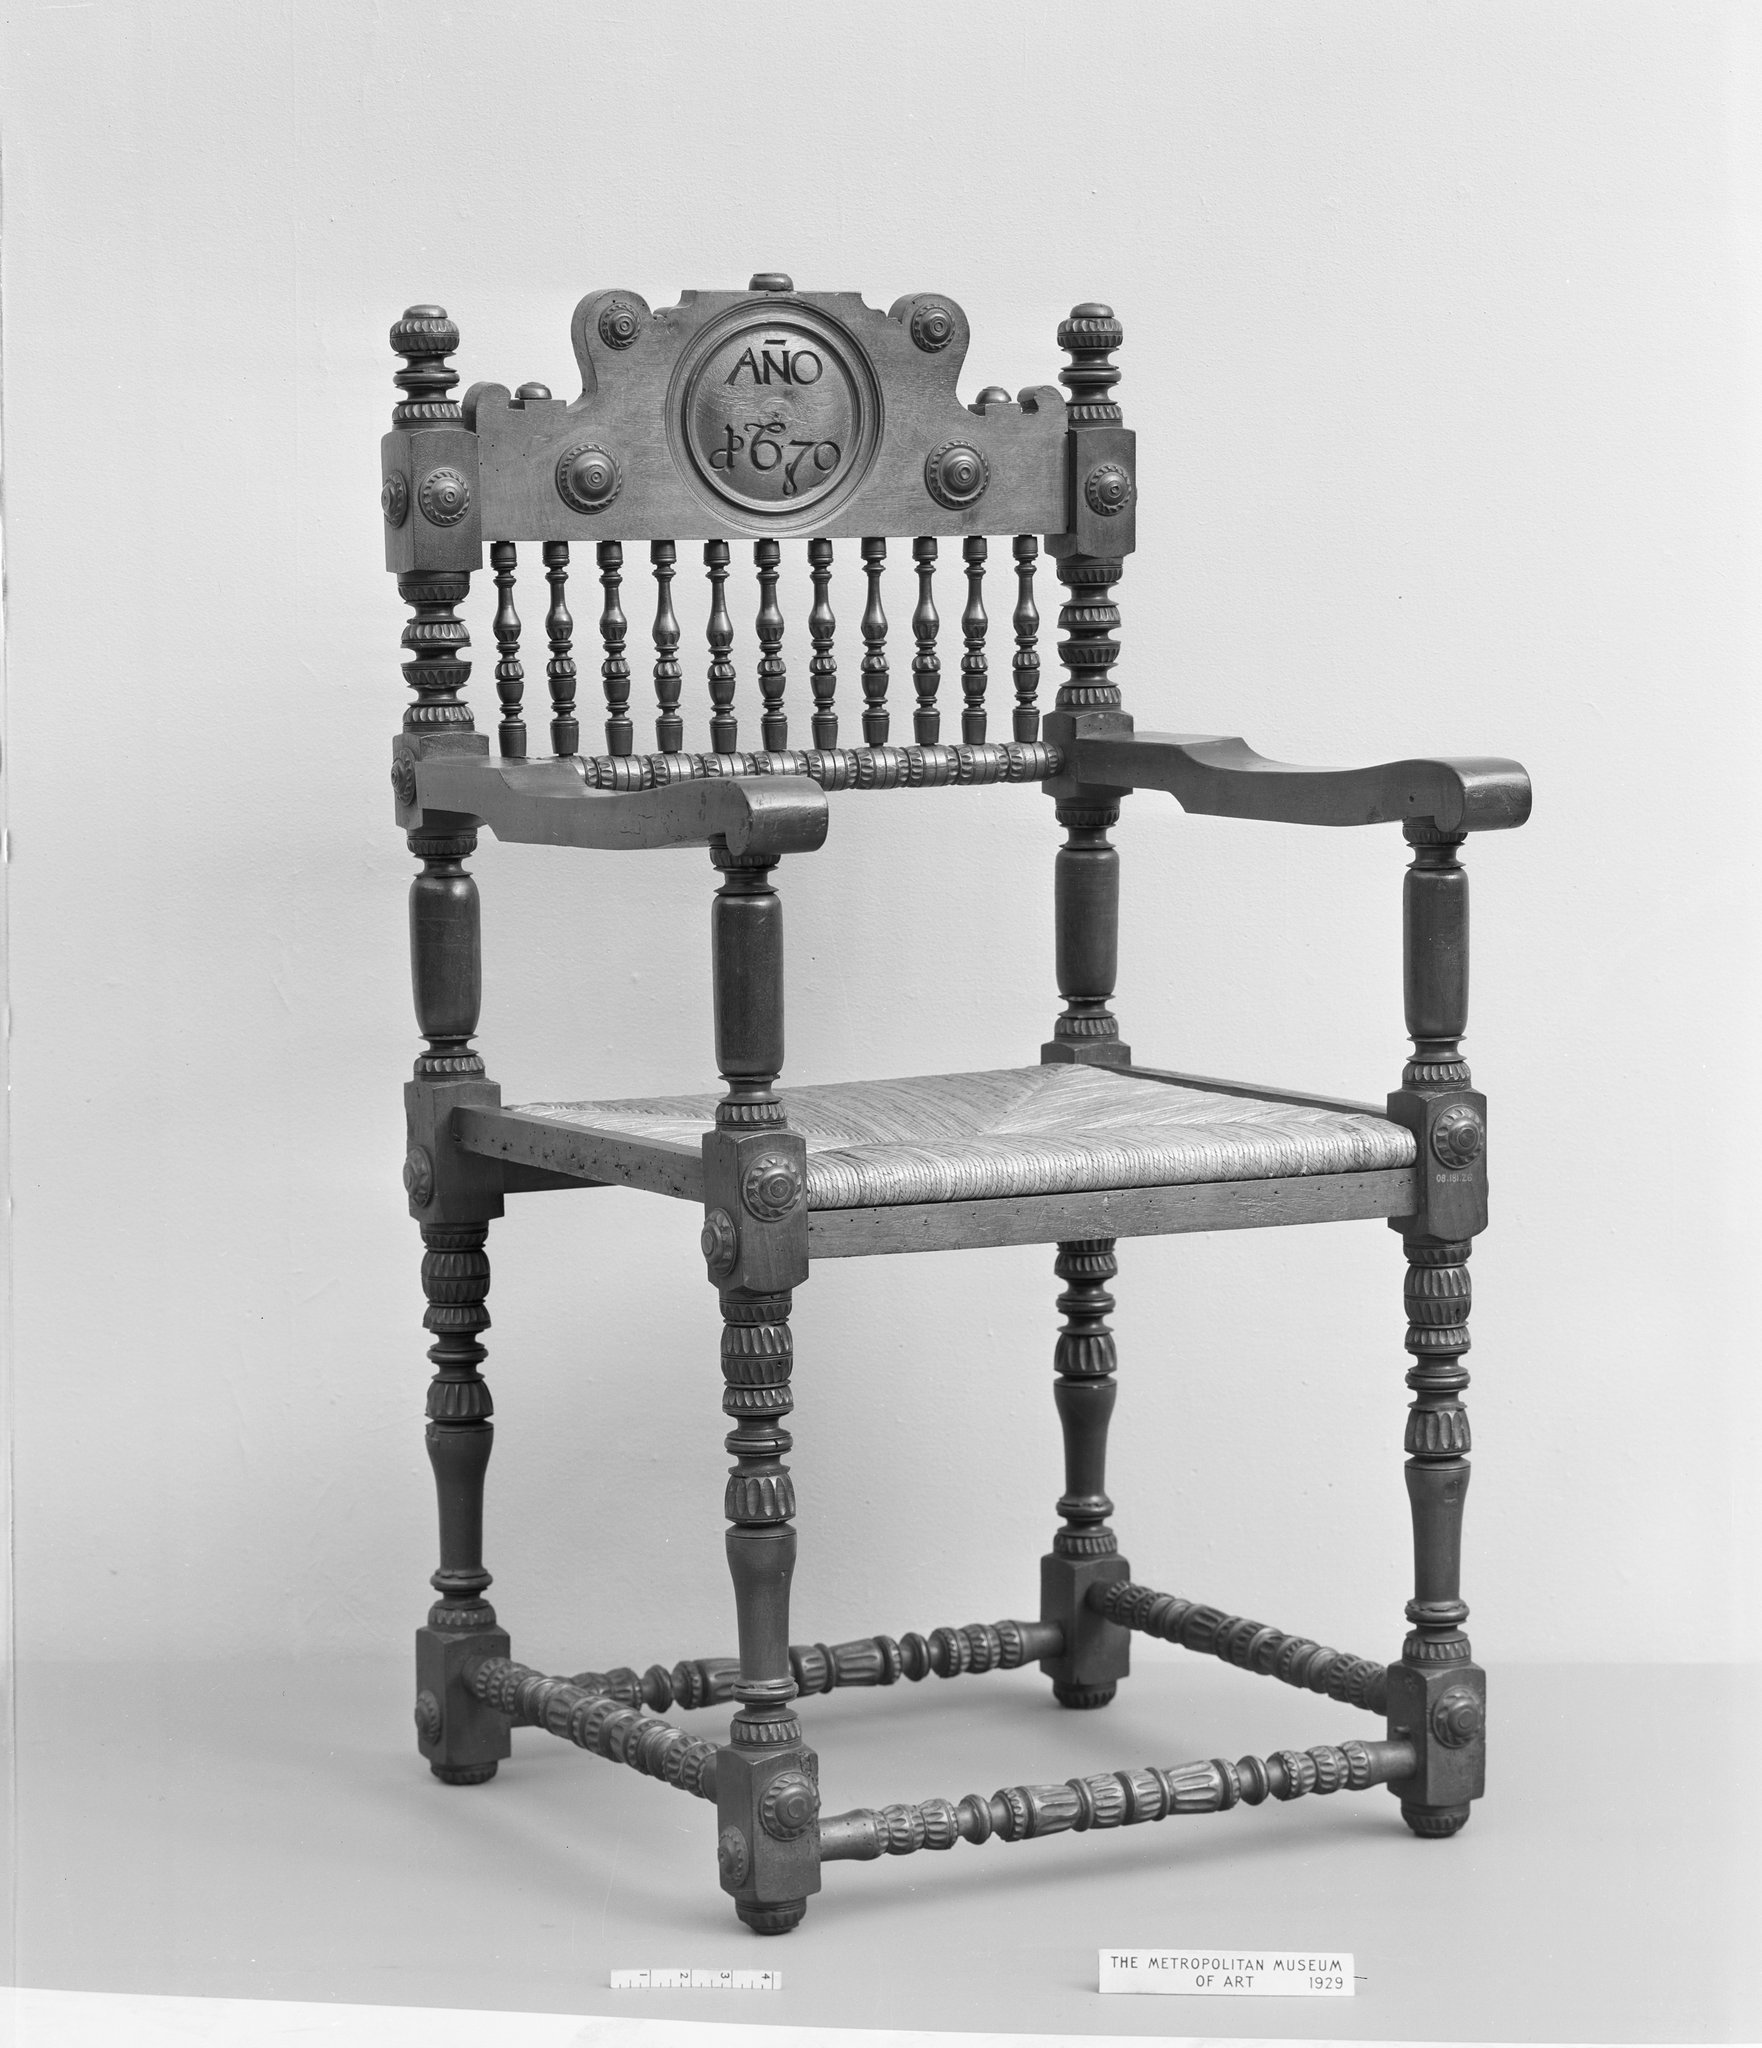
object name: armchair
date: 1679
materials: fiber, wood